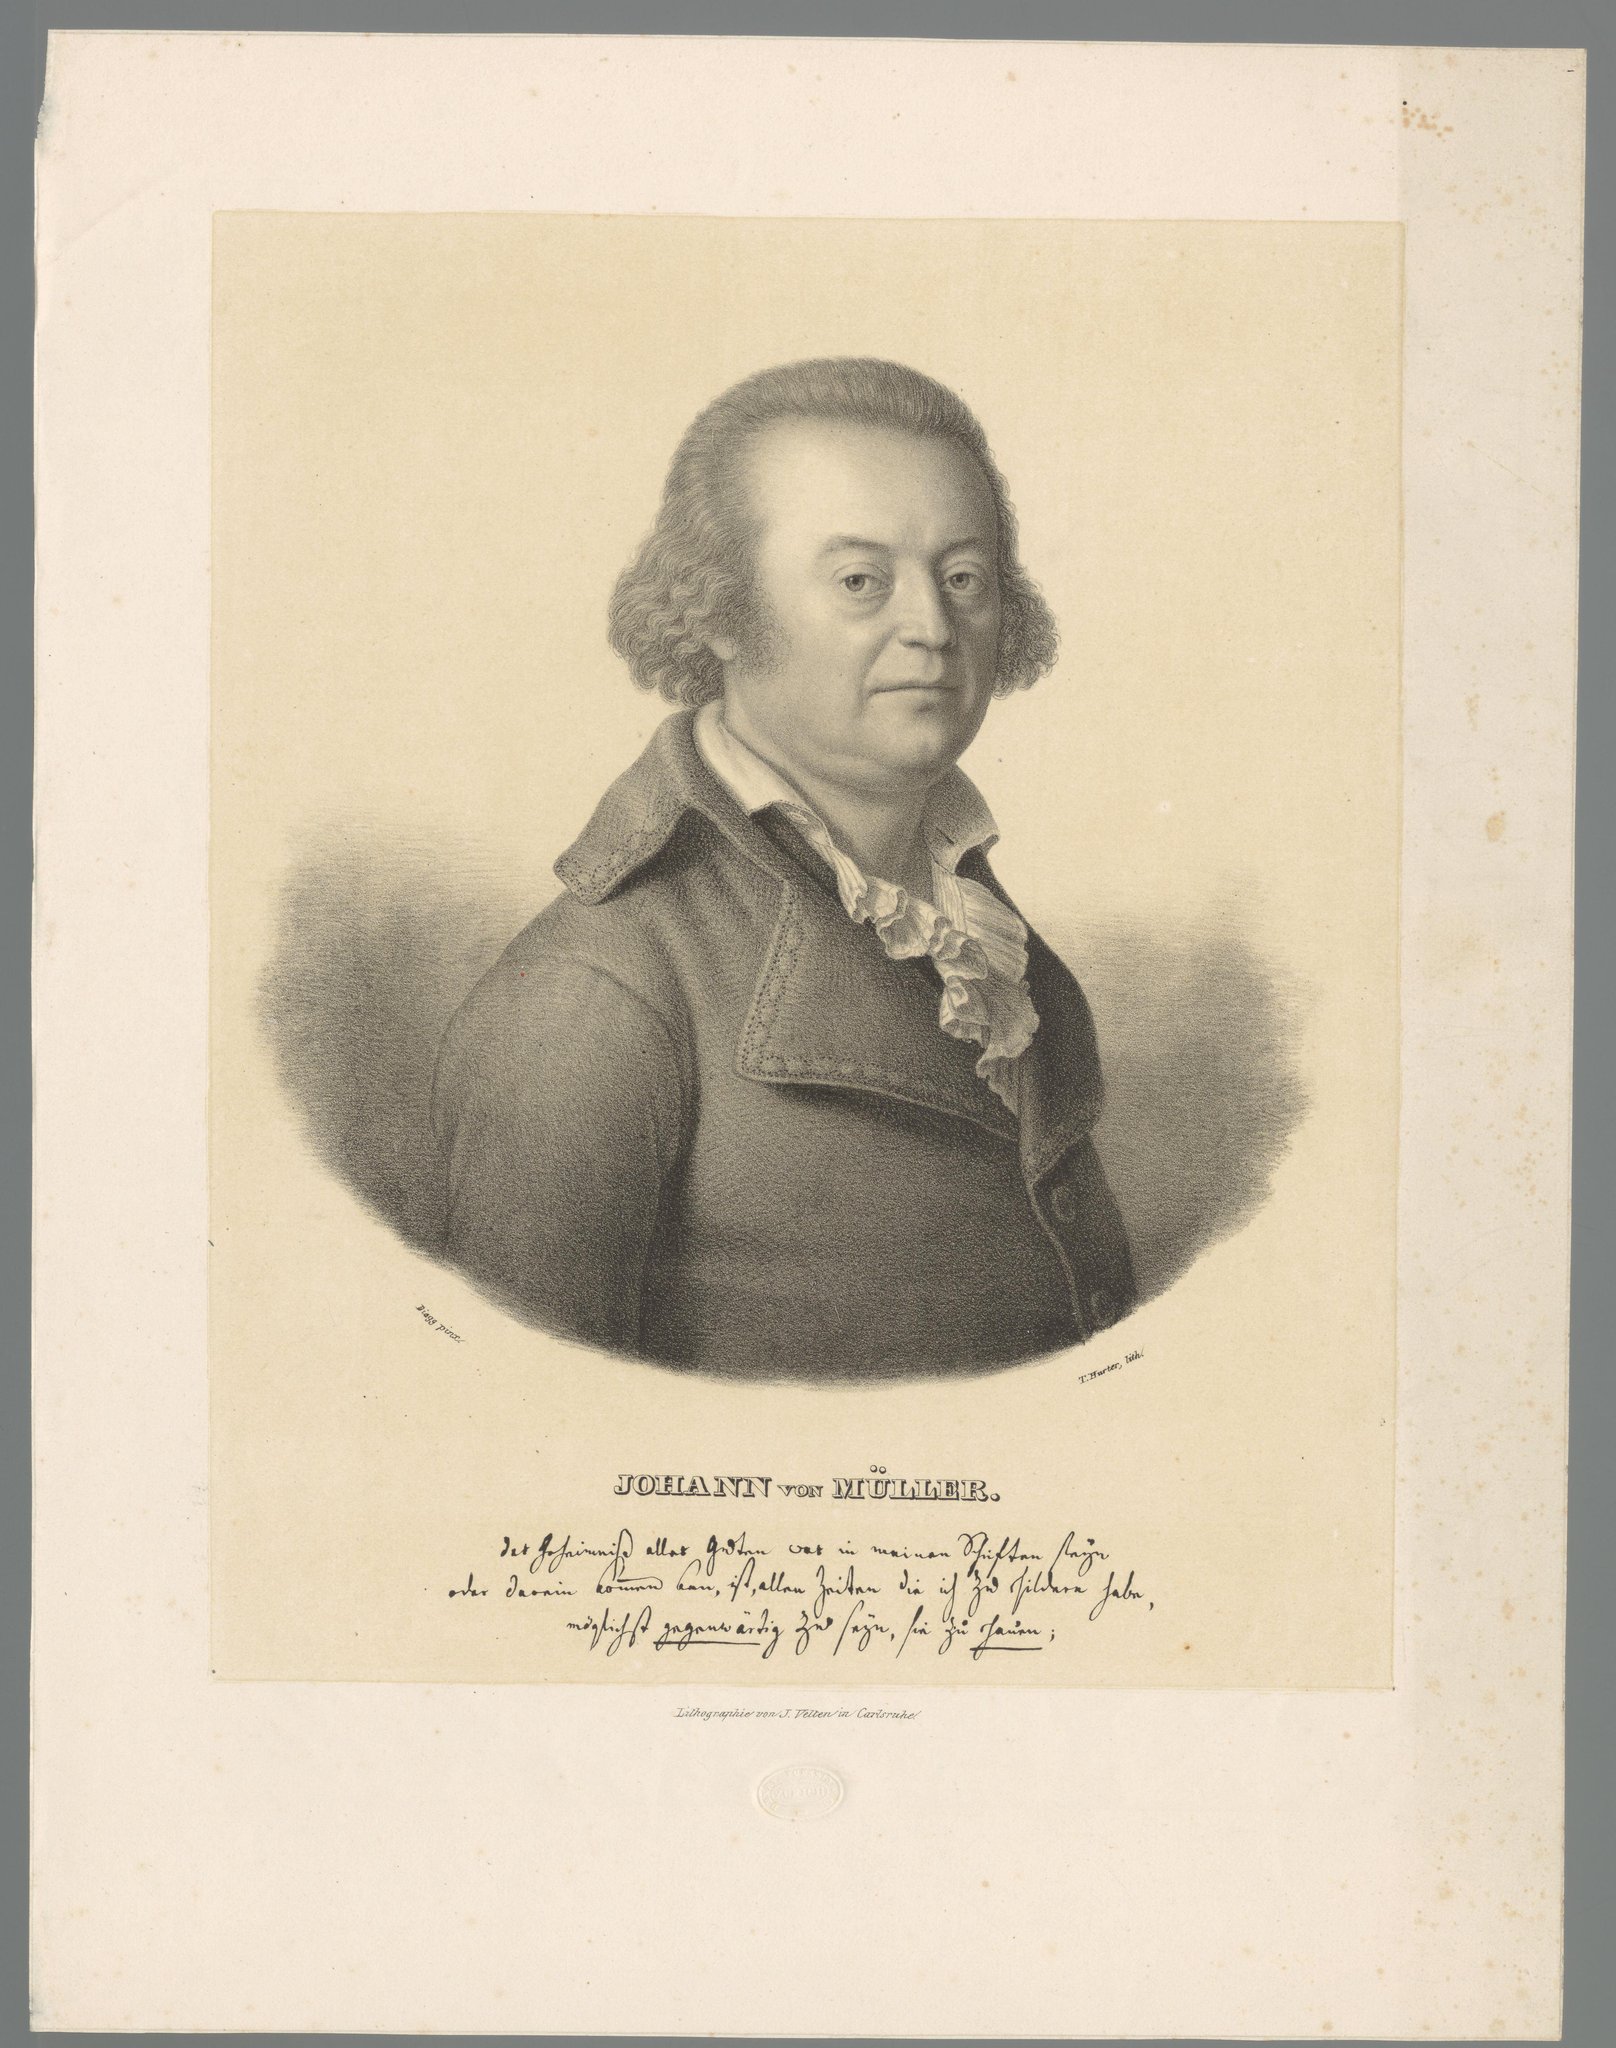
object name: print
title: Portret van Johannes von Müller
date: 1813-1889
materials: paper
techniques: tone lithography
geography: karlsruhe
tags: adult man, historical persons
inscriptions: collector's mark: Lugt 2228, check stamp: ‘Henry Fuessly &co Zurich’